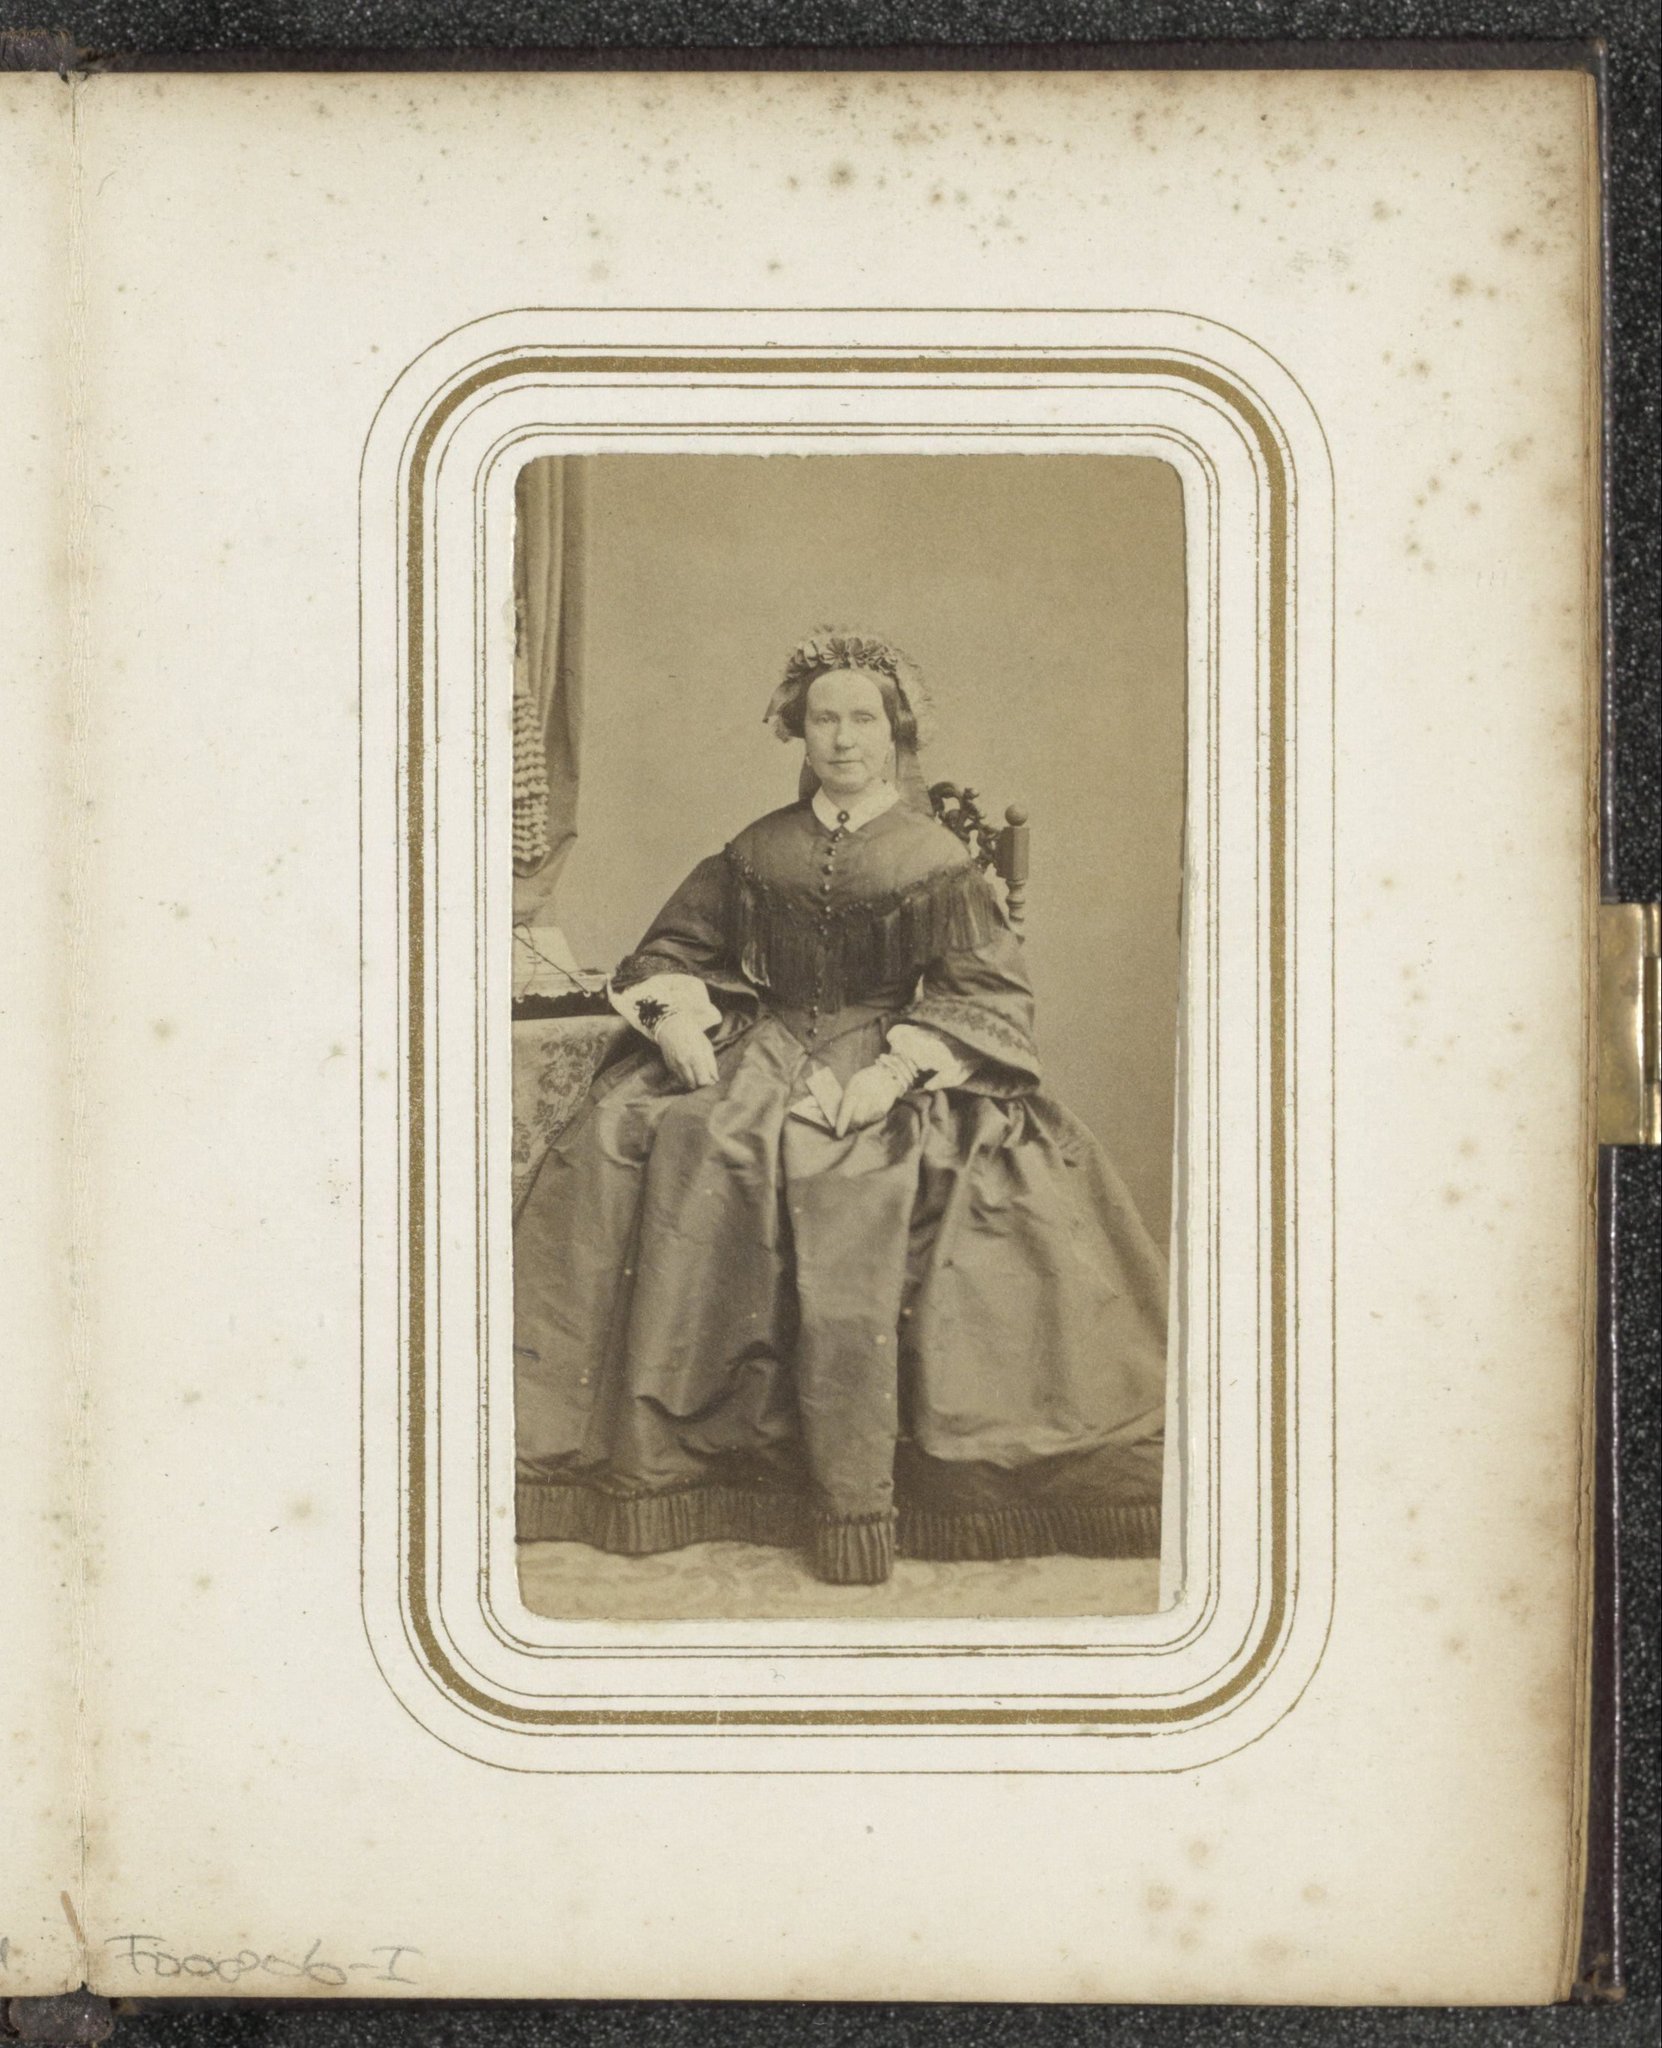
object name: photograph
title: Portret van een zittende vrouw met een muts en (mogelijk) een fotoalbum in de hand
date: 1862-1869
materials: cardboard, paper, photographic support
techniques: albumen print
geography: haarlem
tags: studio requisites ~ photographer, historical persons, neck-gear ~ clothing, brooch, agraffe, clasp, book, head-gear: cap, dress, gown, haarlem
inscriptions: address: ‘Zijlstraat No. 759 Haarlem.’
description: Onderdeel van Fotoalbum met 36 cartes-de-visite van Nederlandse personen.